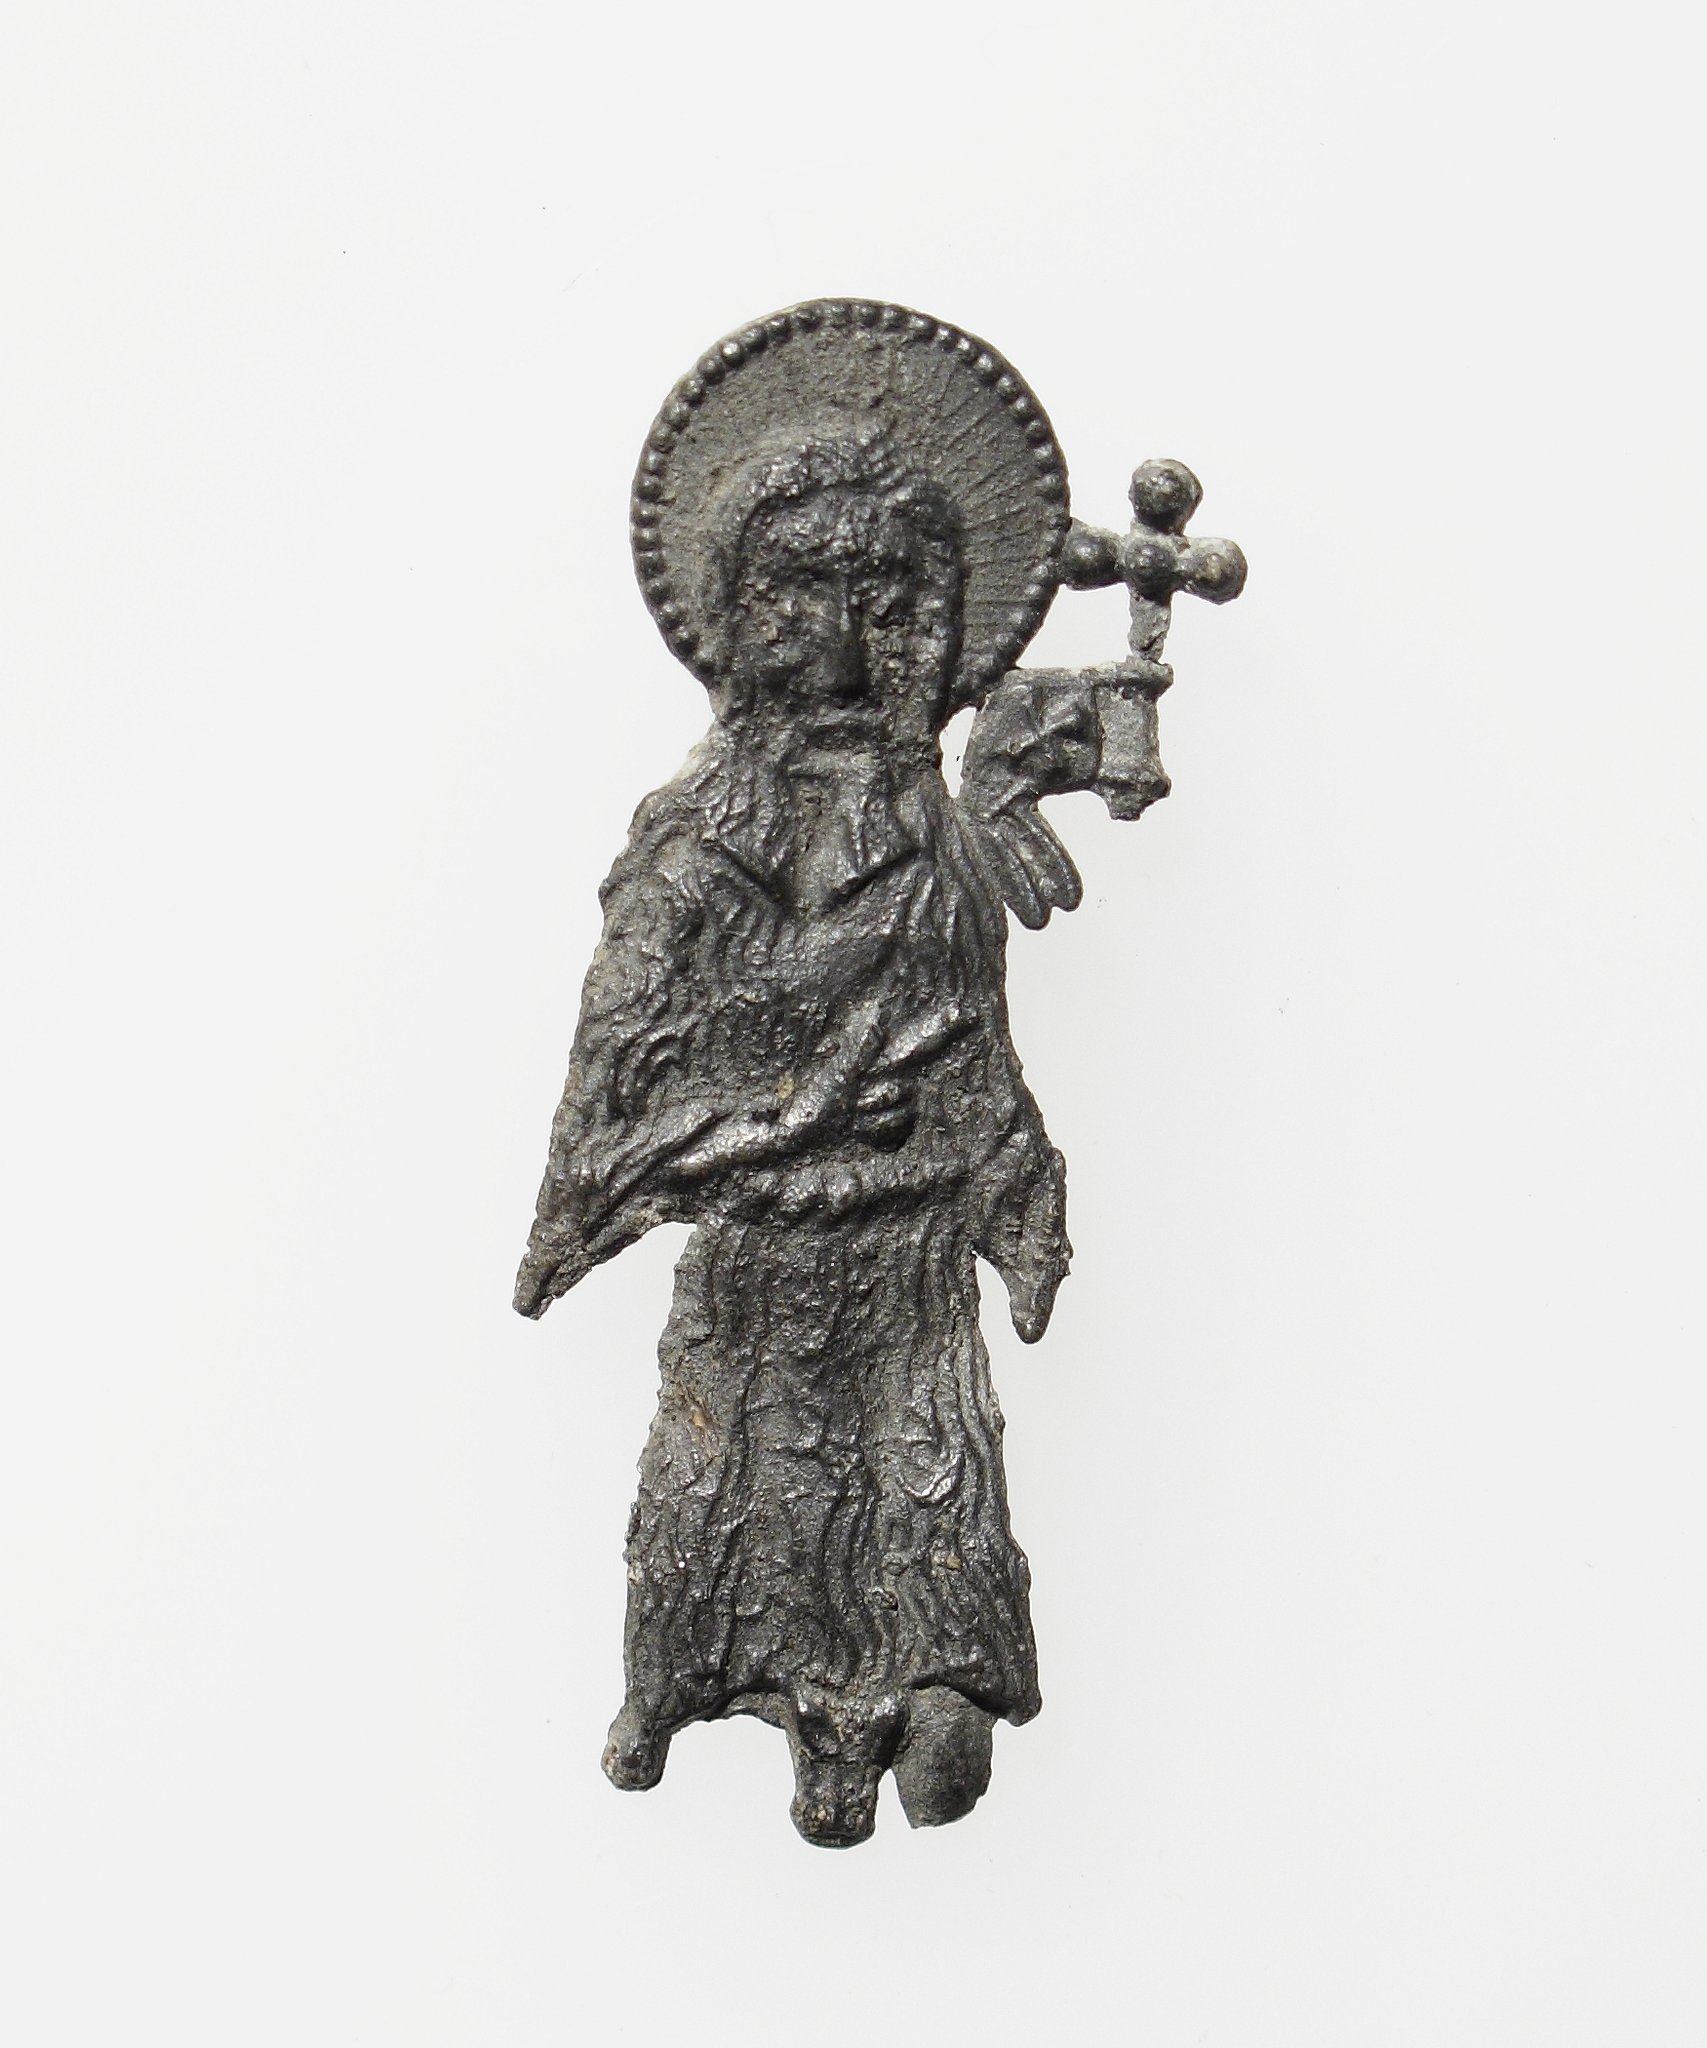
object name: pilgrim's badge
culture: french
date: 1401-1500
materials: lead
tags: saint john the baptist